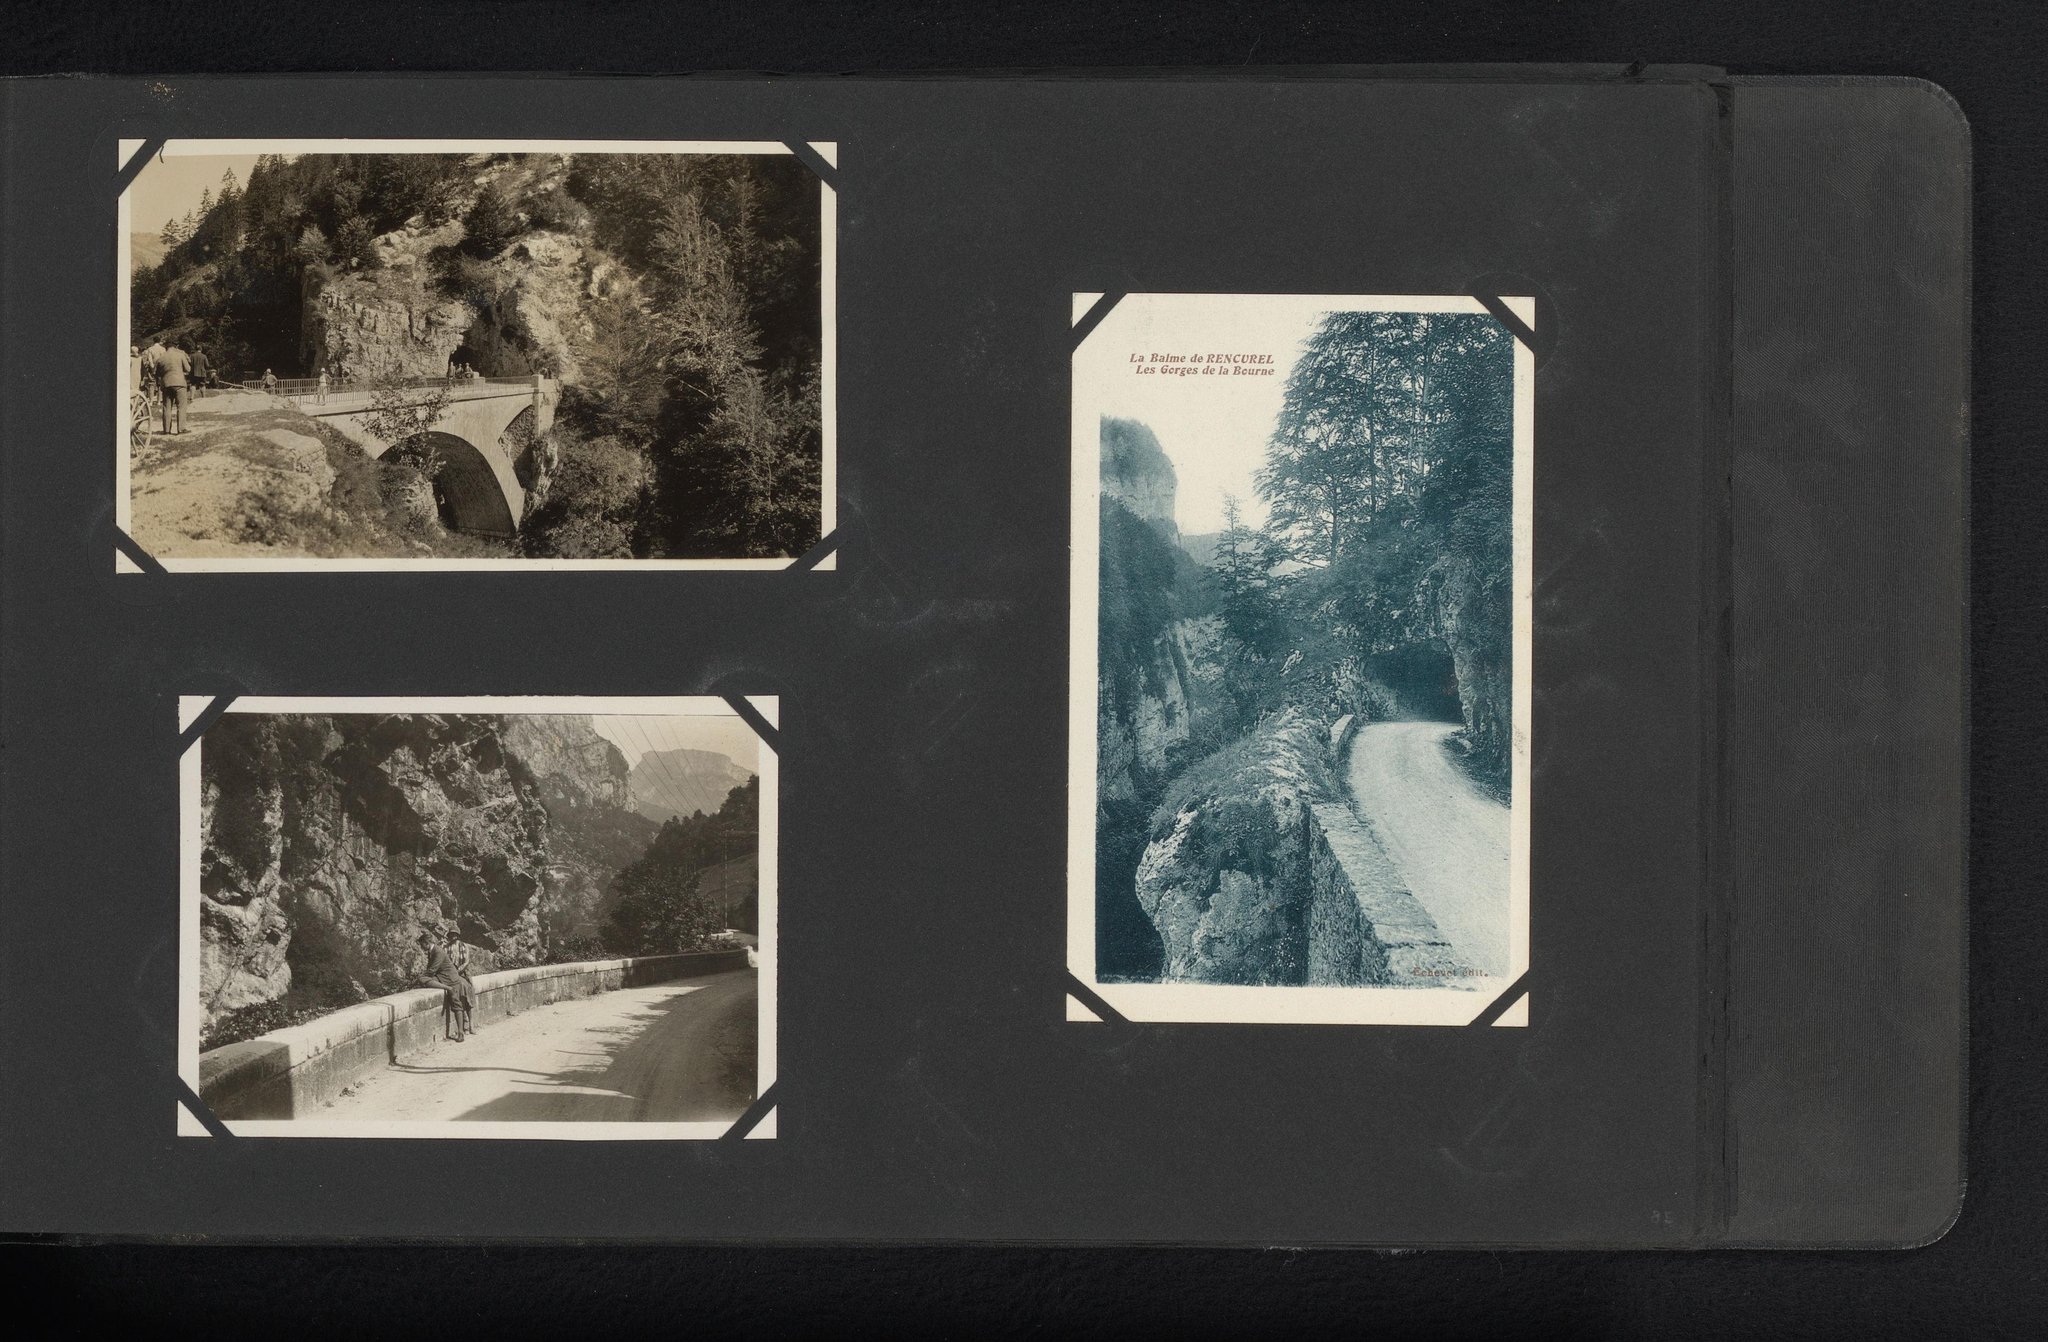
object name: photograph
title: Twee foto's en een fotomechanische prentbriefkaart van de bergen rond Grenoble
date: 1908-1929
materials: paper, cardboard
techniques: photograph, gelatin silver print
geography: isère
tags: mountains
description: Deze prent en foto's maken deel uit van een album.